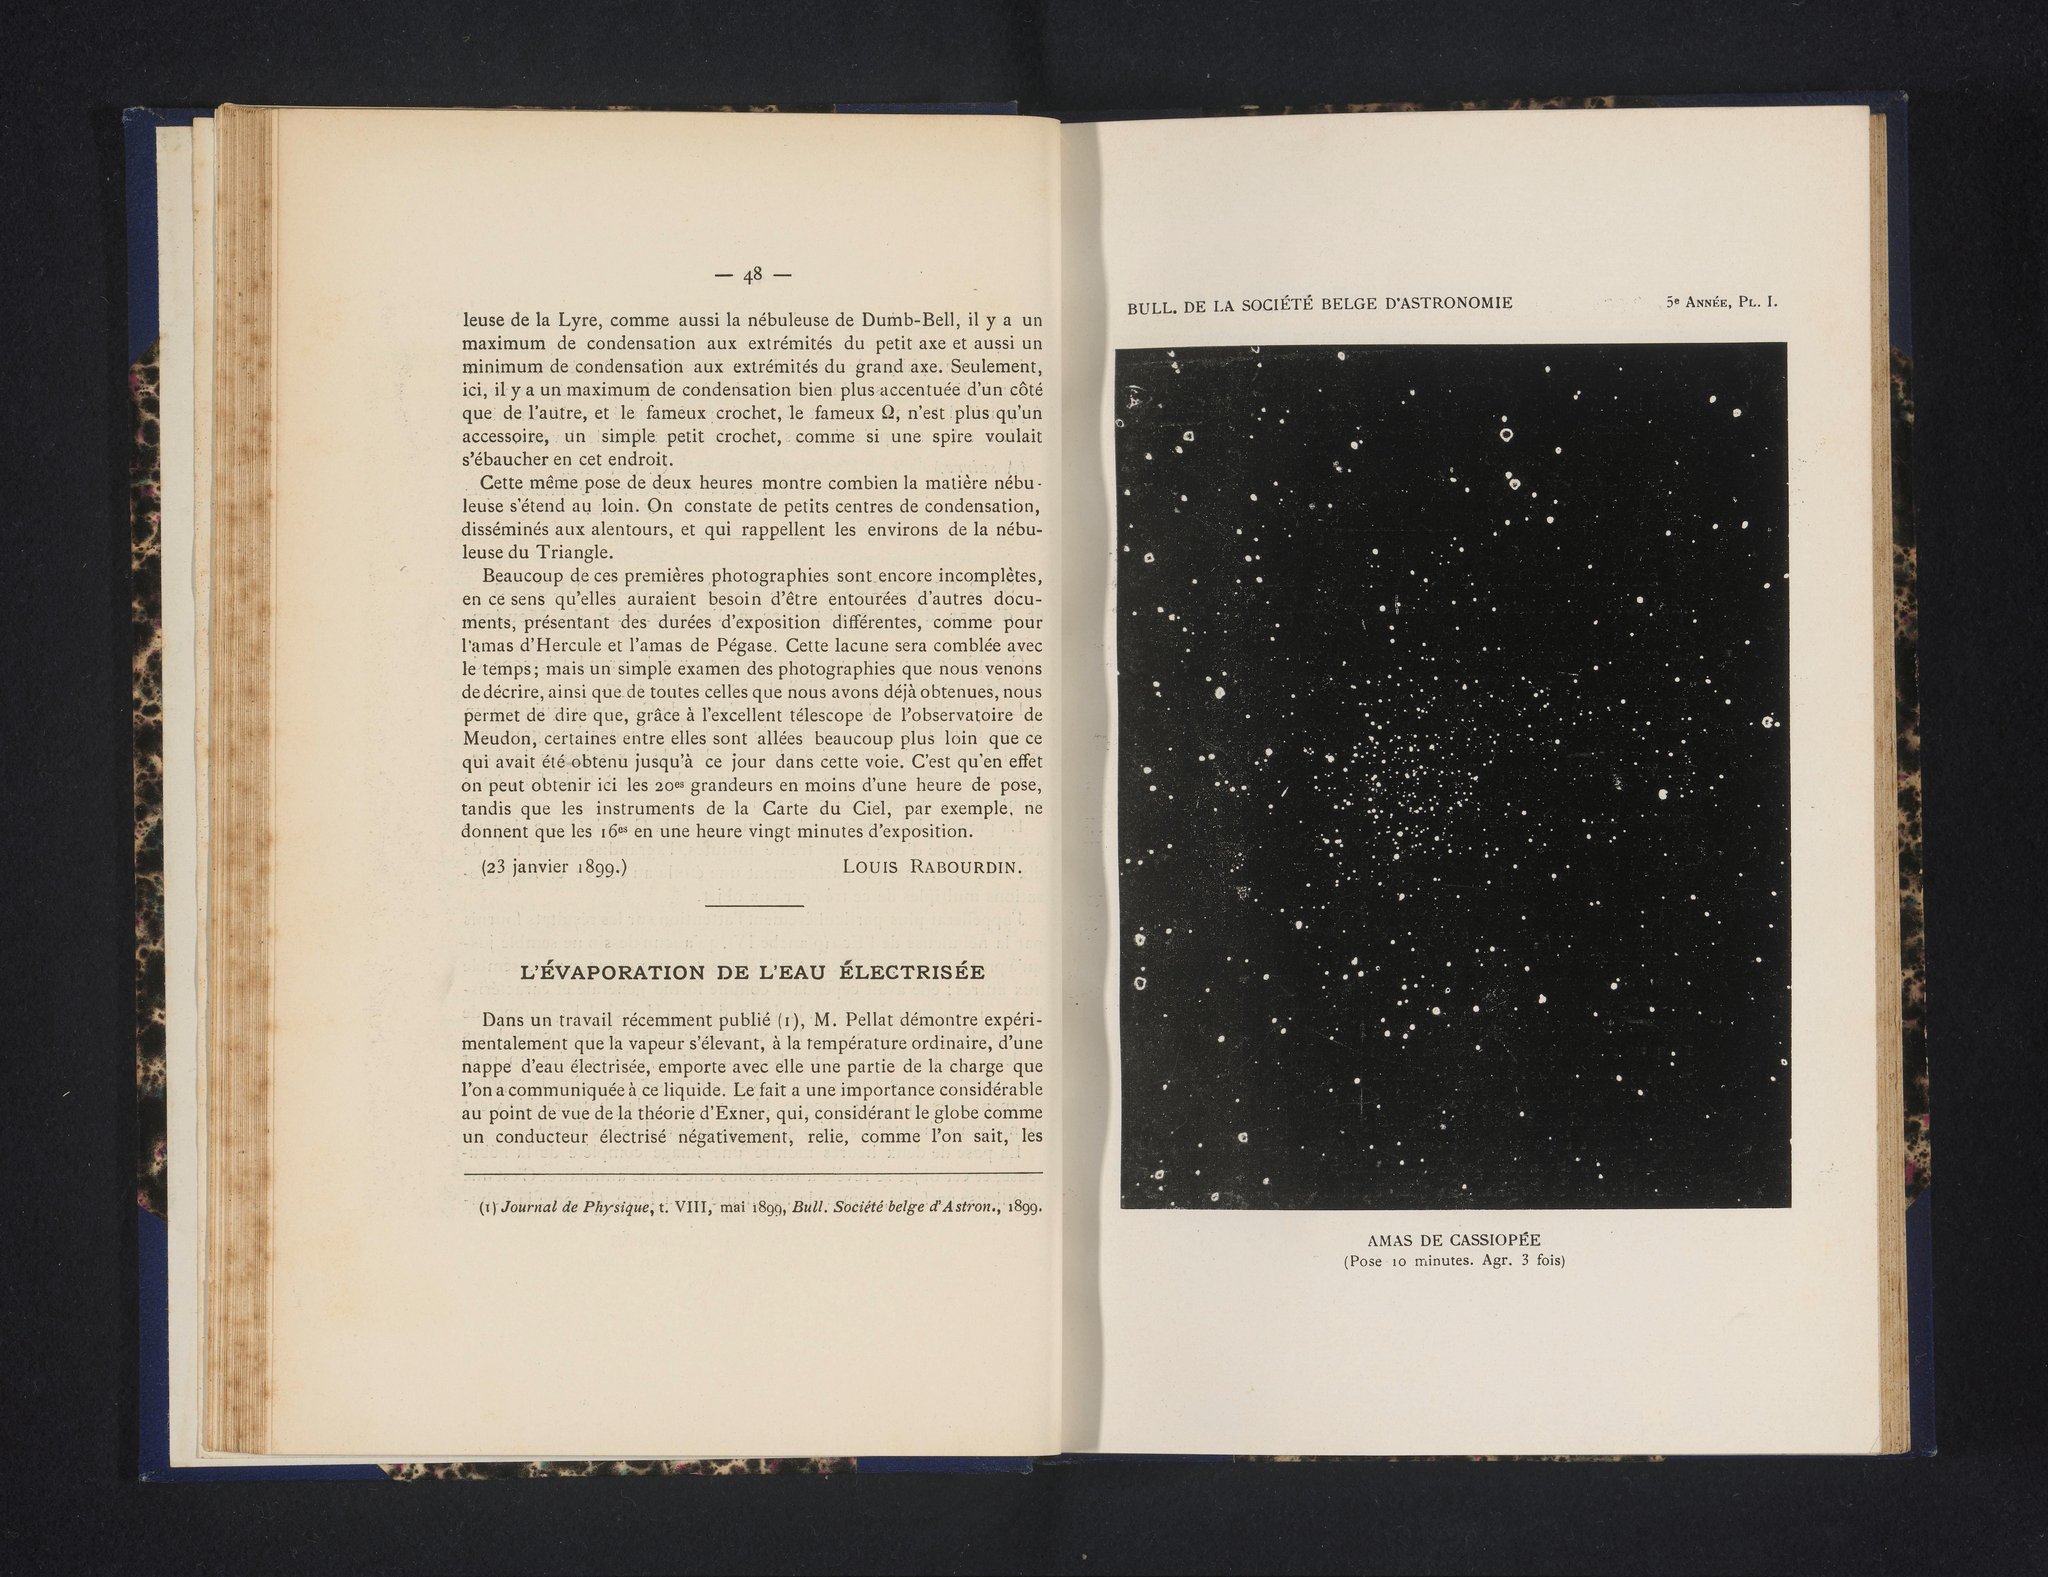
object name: photomechanical print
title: Amas de Cassiopée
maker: Anonymous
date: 1895-1900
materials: paper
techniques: autotype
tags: stars and constellations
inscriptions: inscription: ‘Société Belge D'Astronomie 5e Année, Pl. I’, inscription: ‘Pose 10 minutes. Agr 3 fois.’